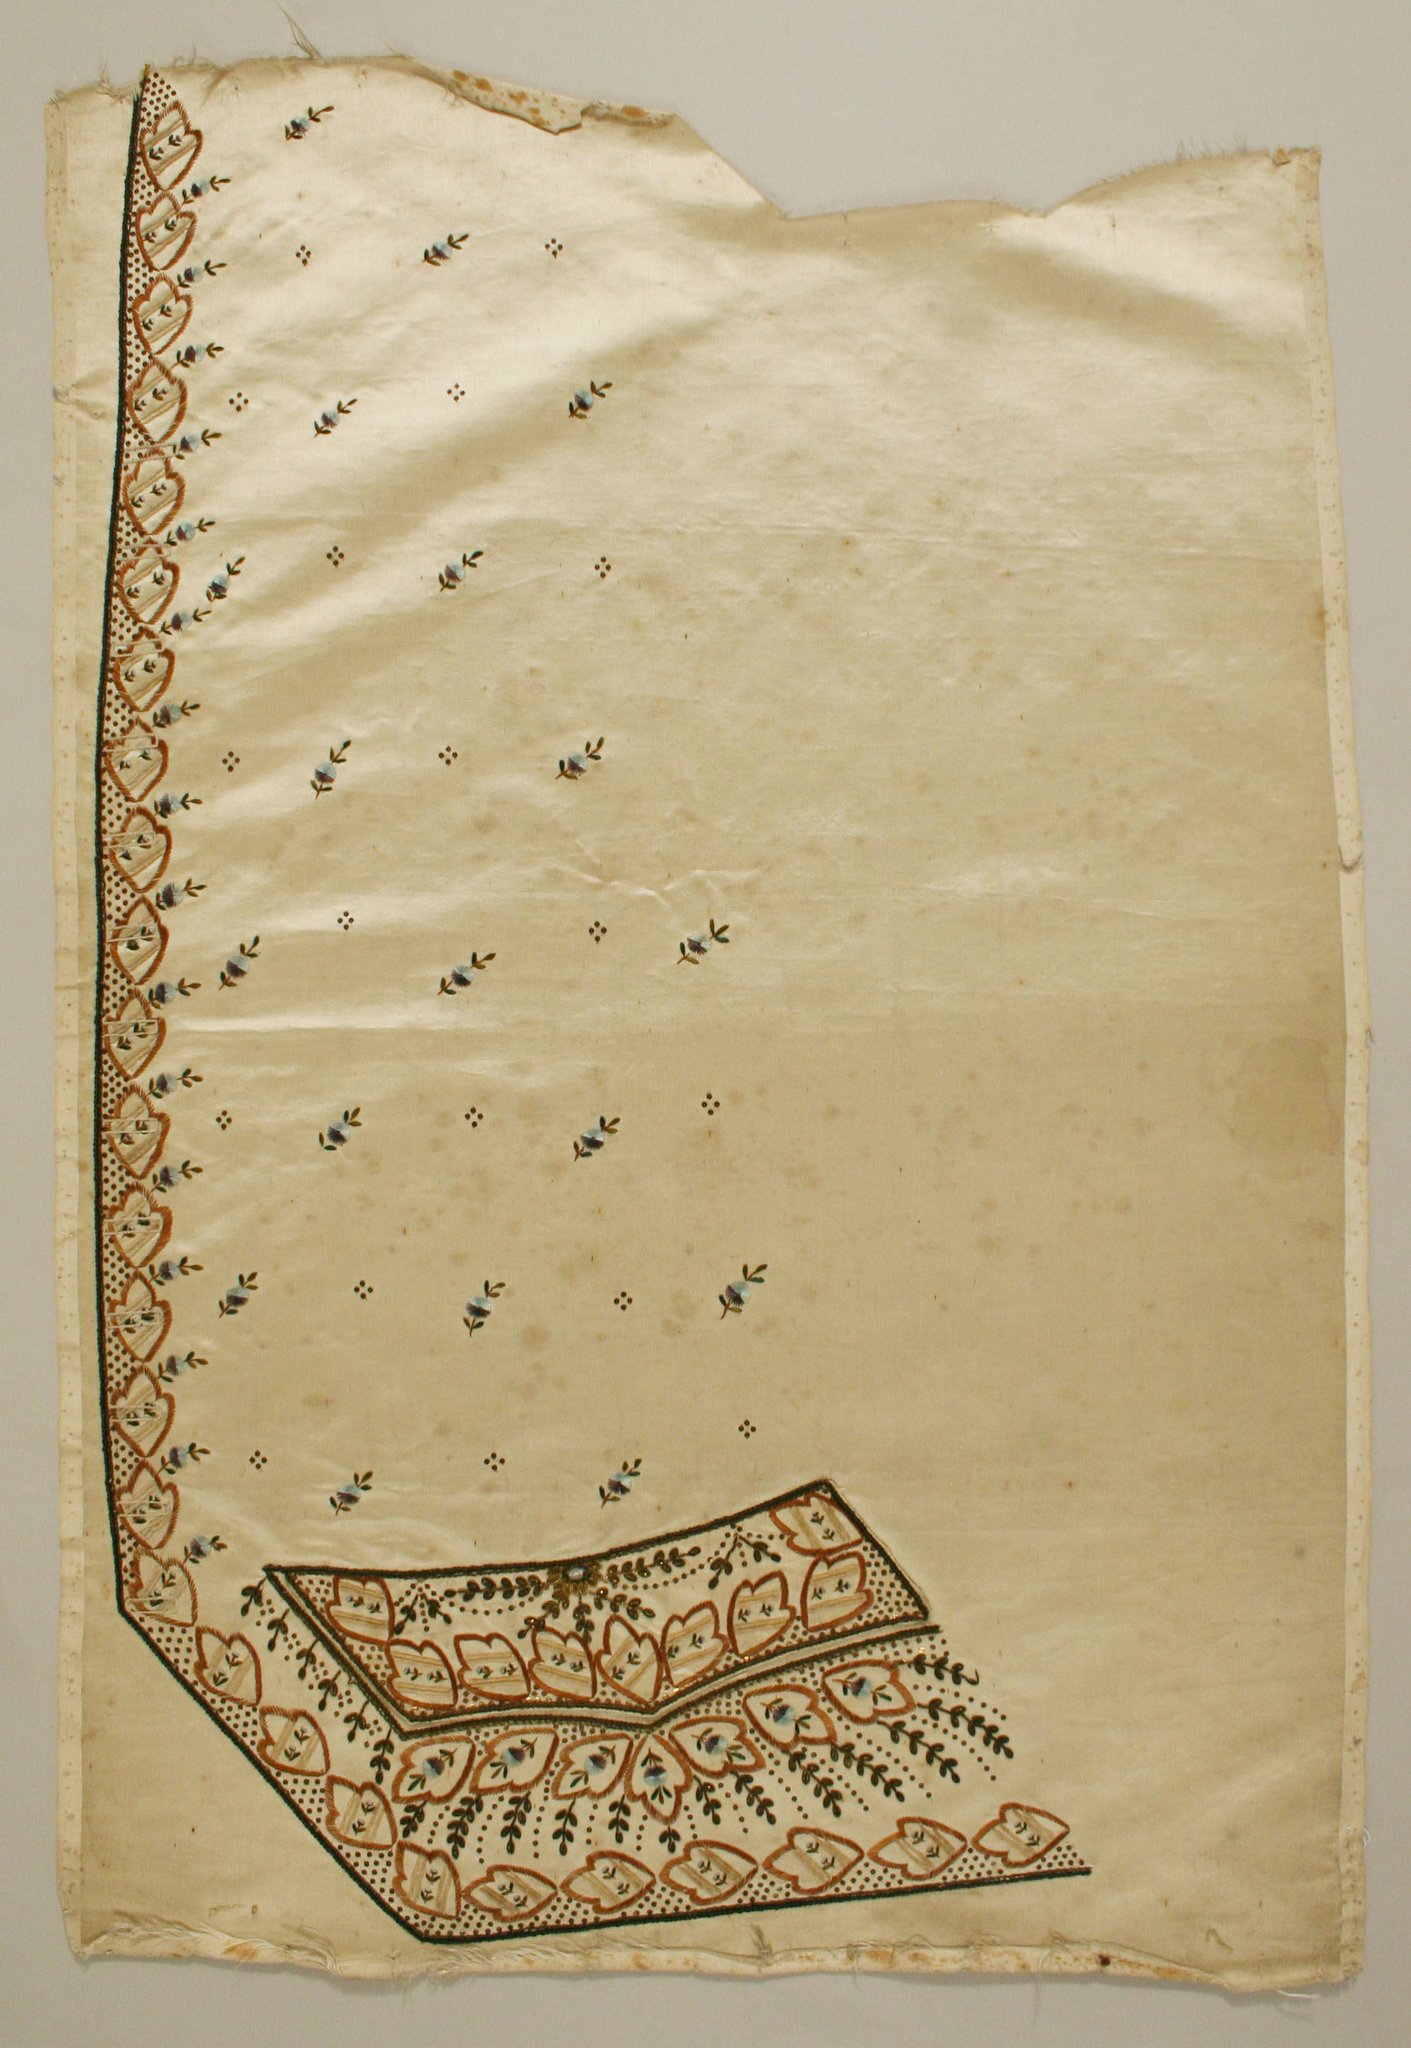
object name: habit à la disposition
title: Waistcoat panels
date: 1780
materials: silk